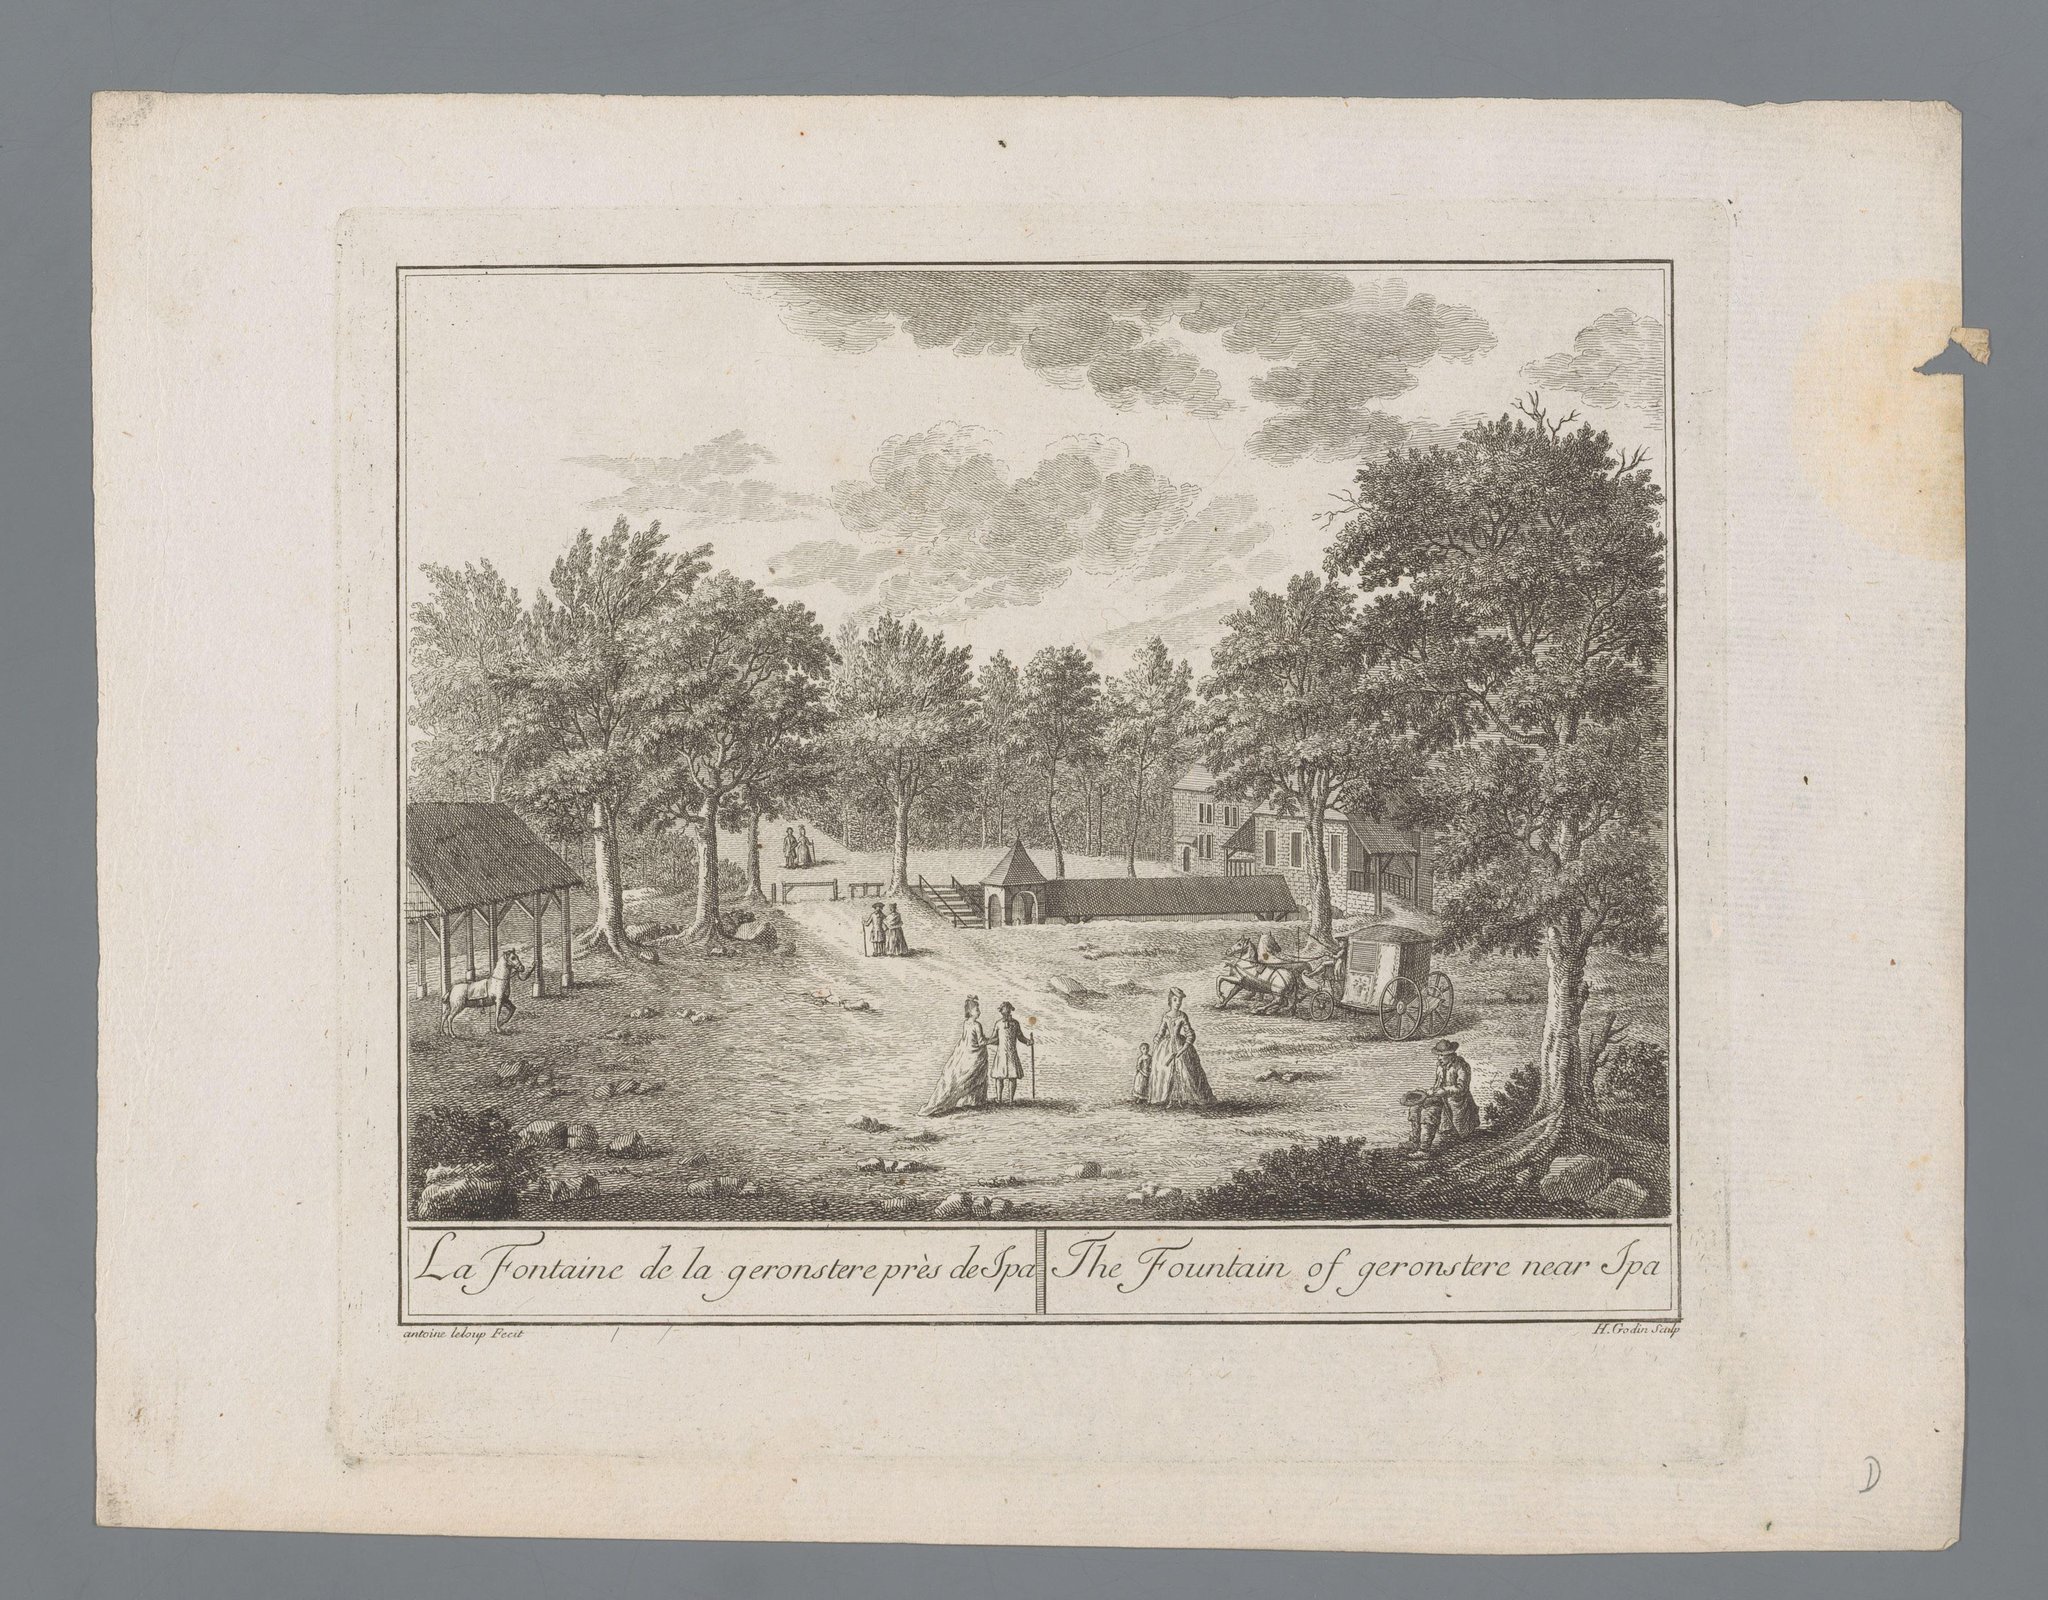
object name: print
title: Gezichten in en nabij Spa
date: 1778-1782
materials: paper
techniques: engraving, etching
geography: liège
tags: medicinal spring